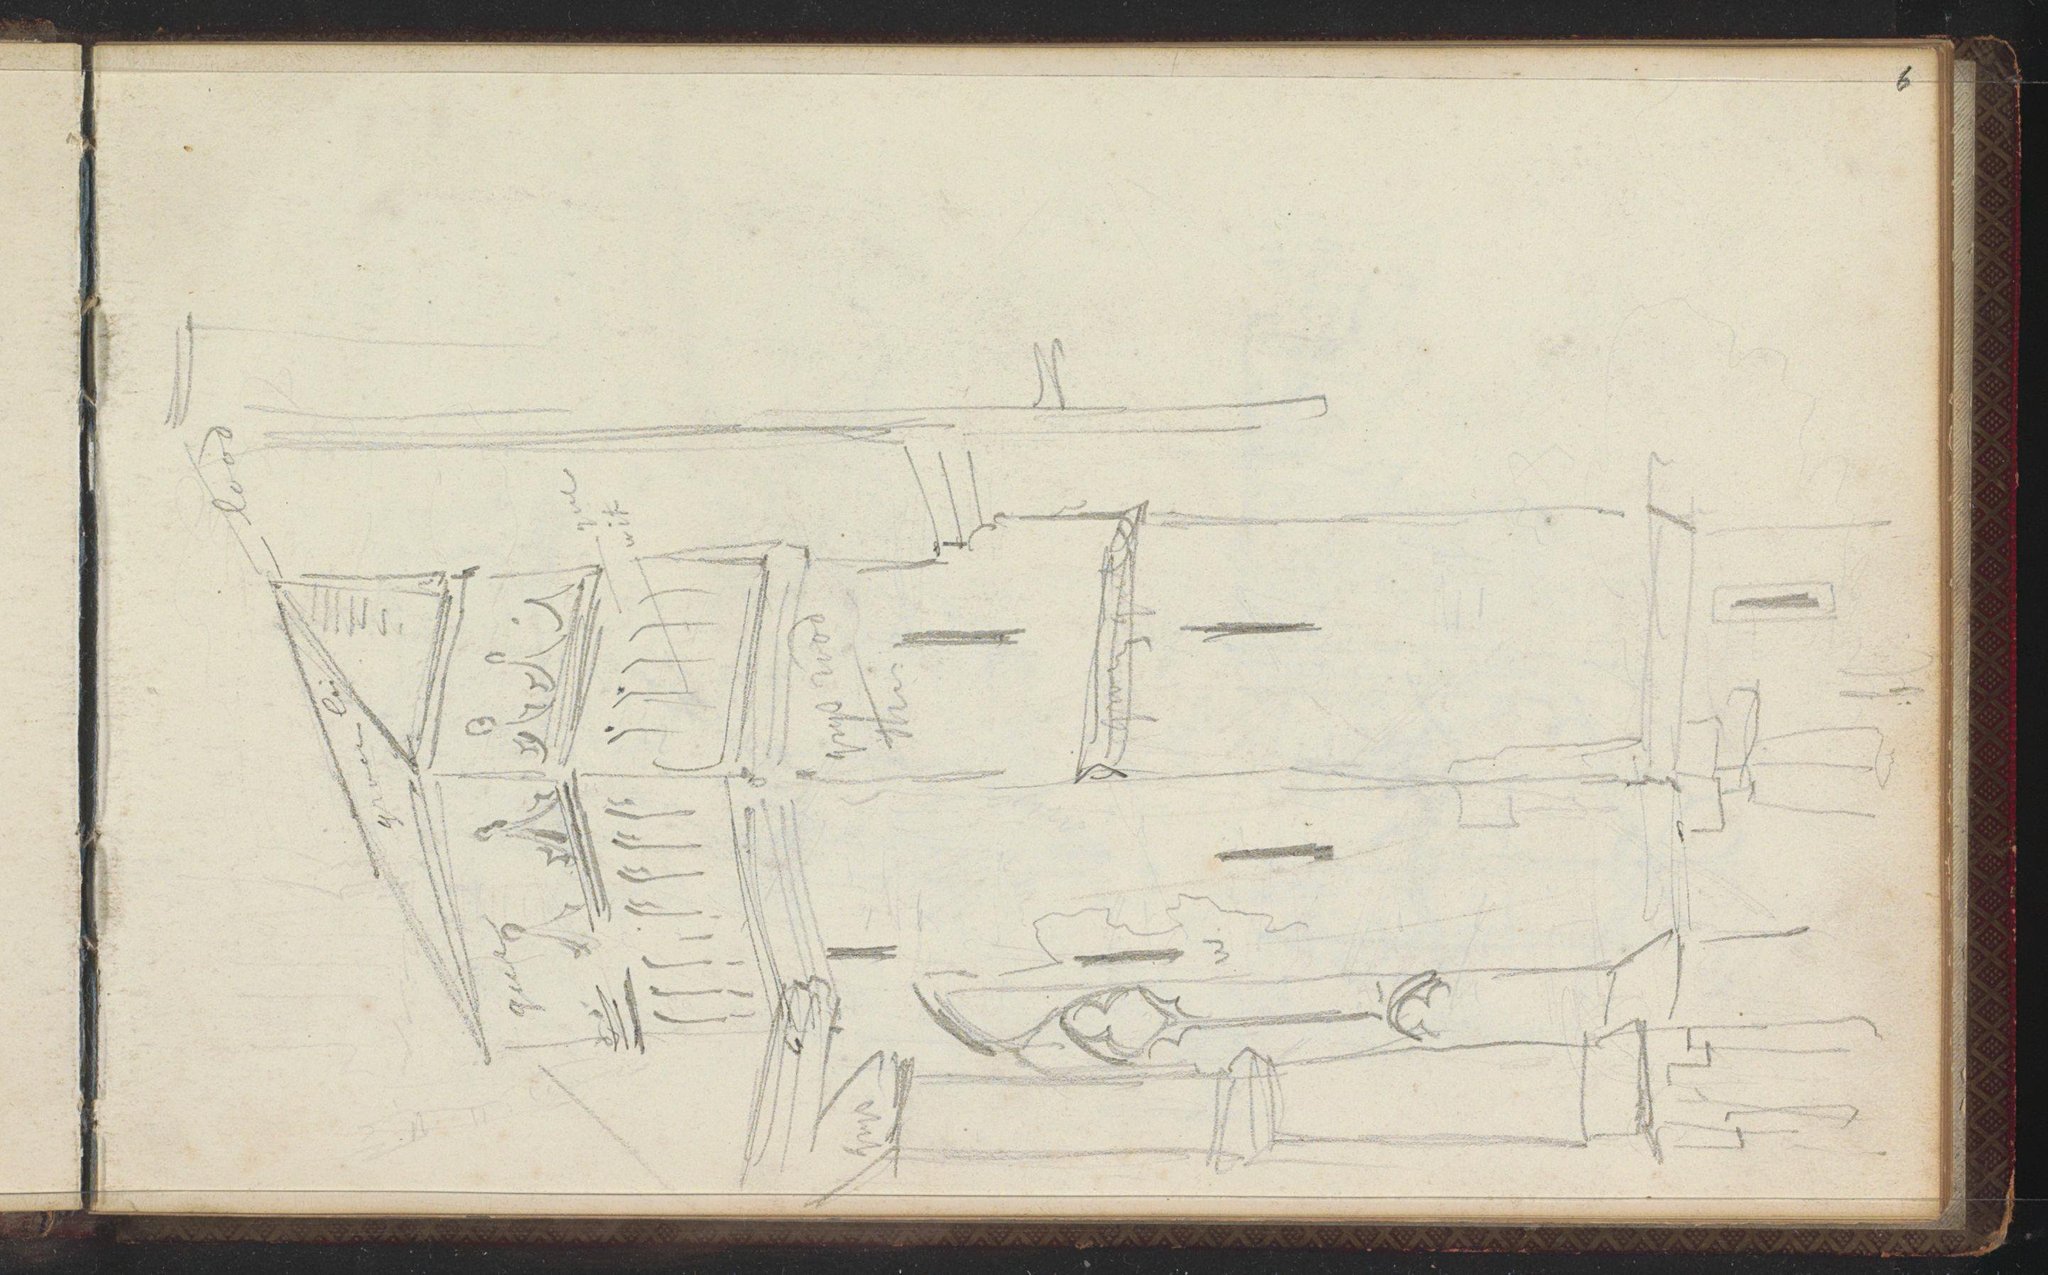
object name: sketchbook leaf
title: Architectuurstudie, mogelijk van een kerk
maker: adrianus eversen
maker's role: draughtsman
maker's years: 1818-1897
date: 1828-1897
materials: paper, pencil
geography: netherlands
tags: architectural detail, church (exterior)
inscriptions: kleurnotitie, handgeschreven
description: Architectuurstudie, mogelijk van een kerk. Blad 6 recto uit een schetsboek met 52 bladen vervaardigd in de omgeving van Kampen, Hattem, Hoorn en Zwolle.